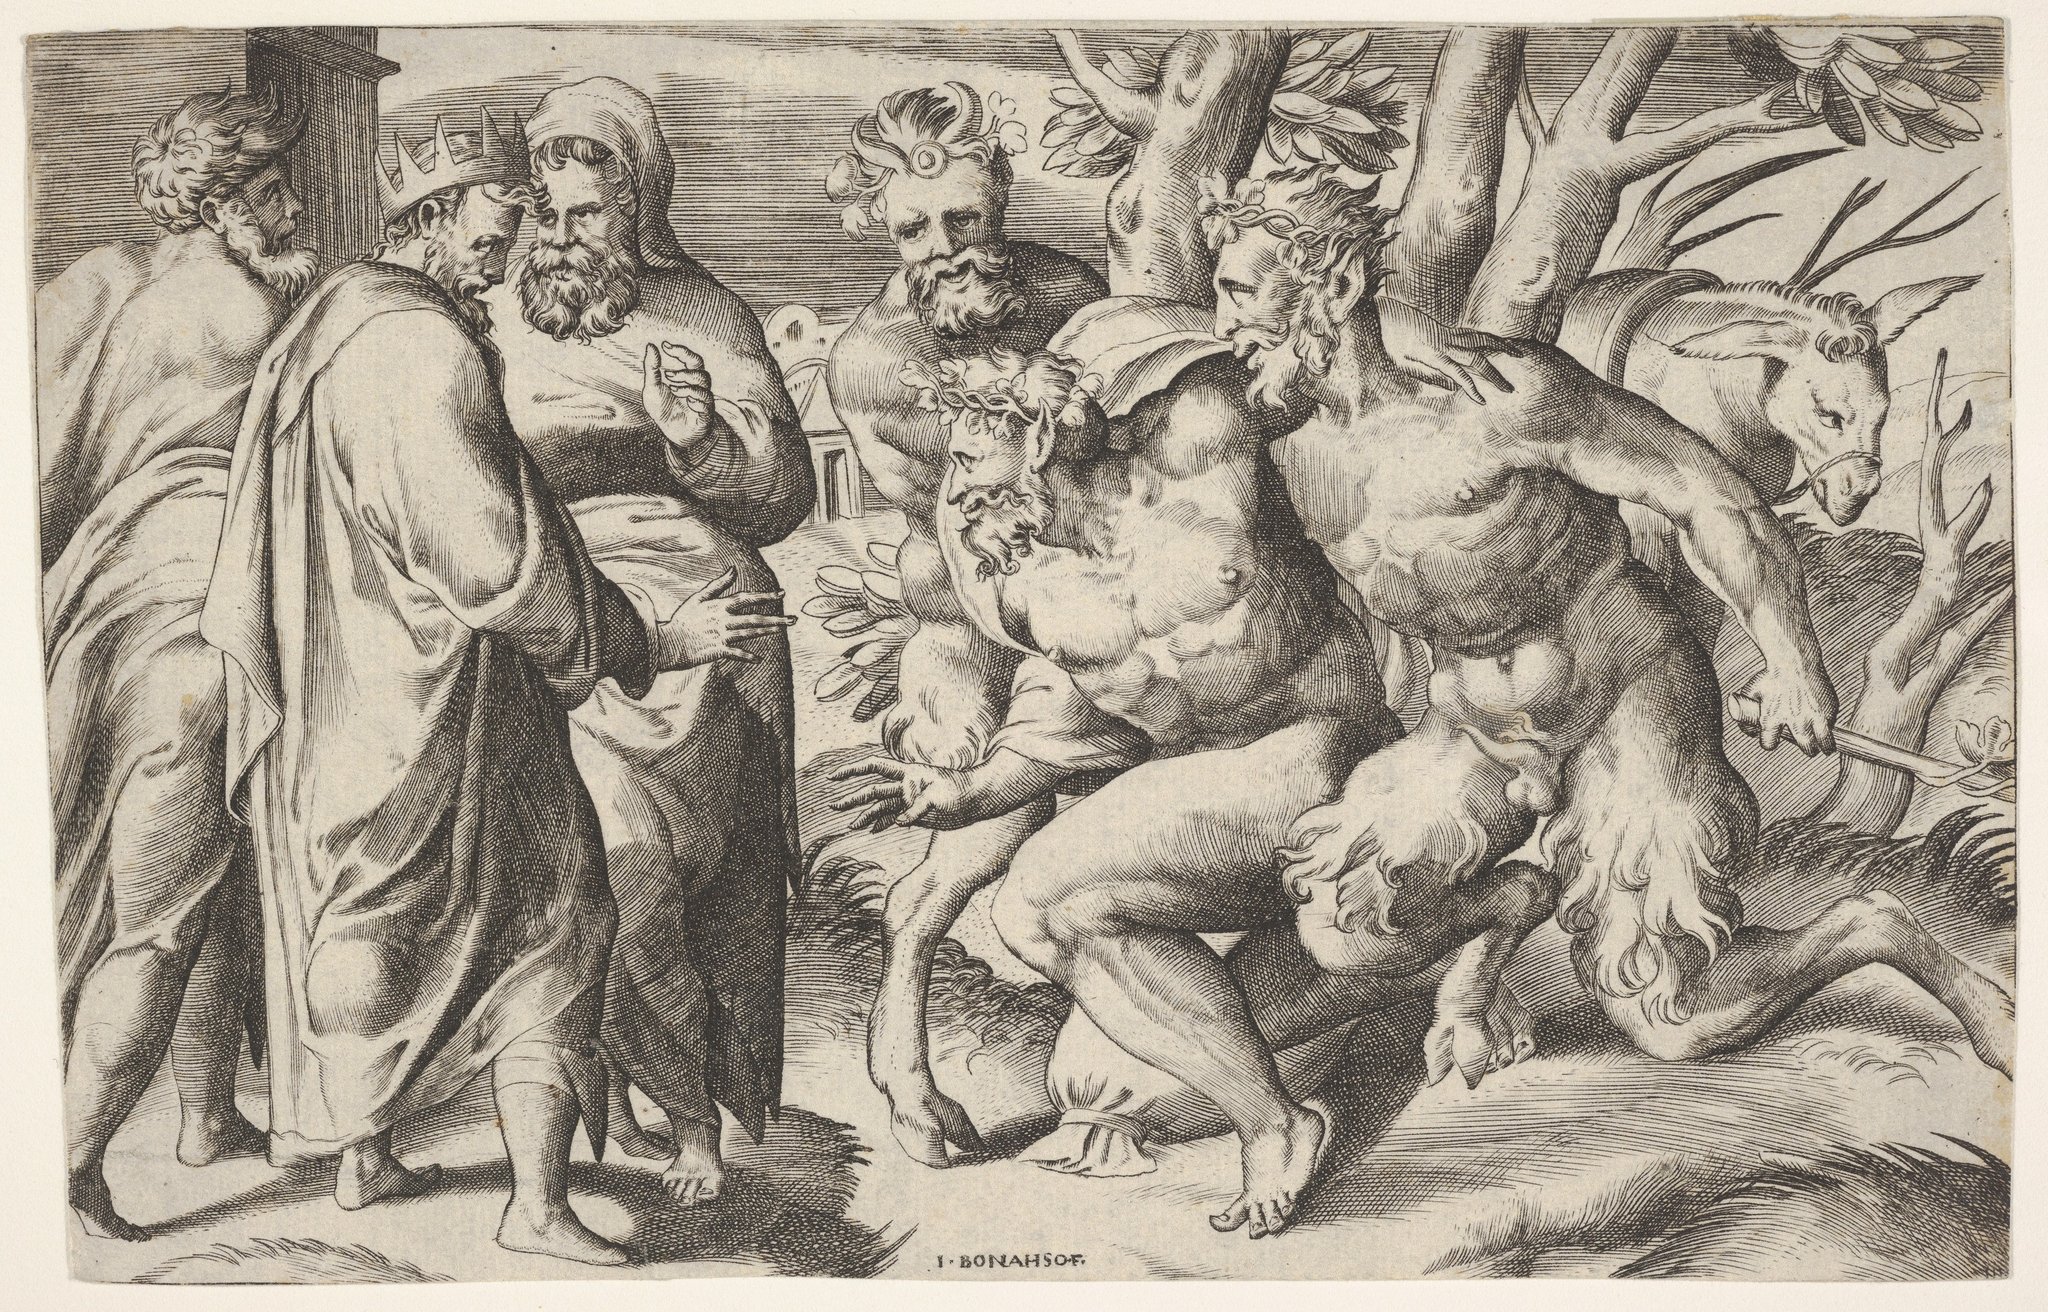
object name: print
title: Two satyrs leading Silenus to King Midas, who stands at left with two male attendants, a mule trails behind the satyrs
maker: giulio bonasone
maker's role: artist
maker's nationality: italian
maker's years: 1510-1576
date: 1550-1580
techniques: engraving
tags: men,silenus,midas,satyrs